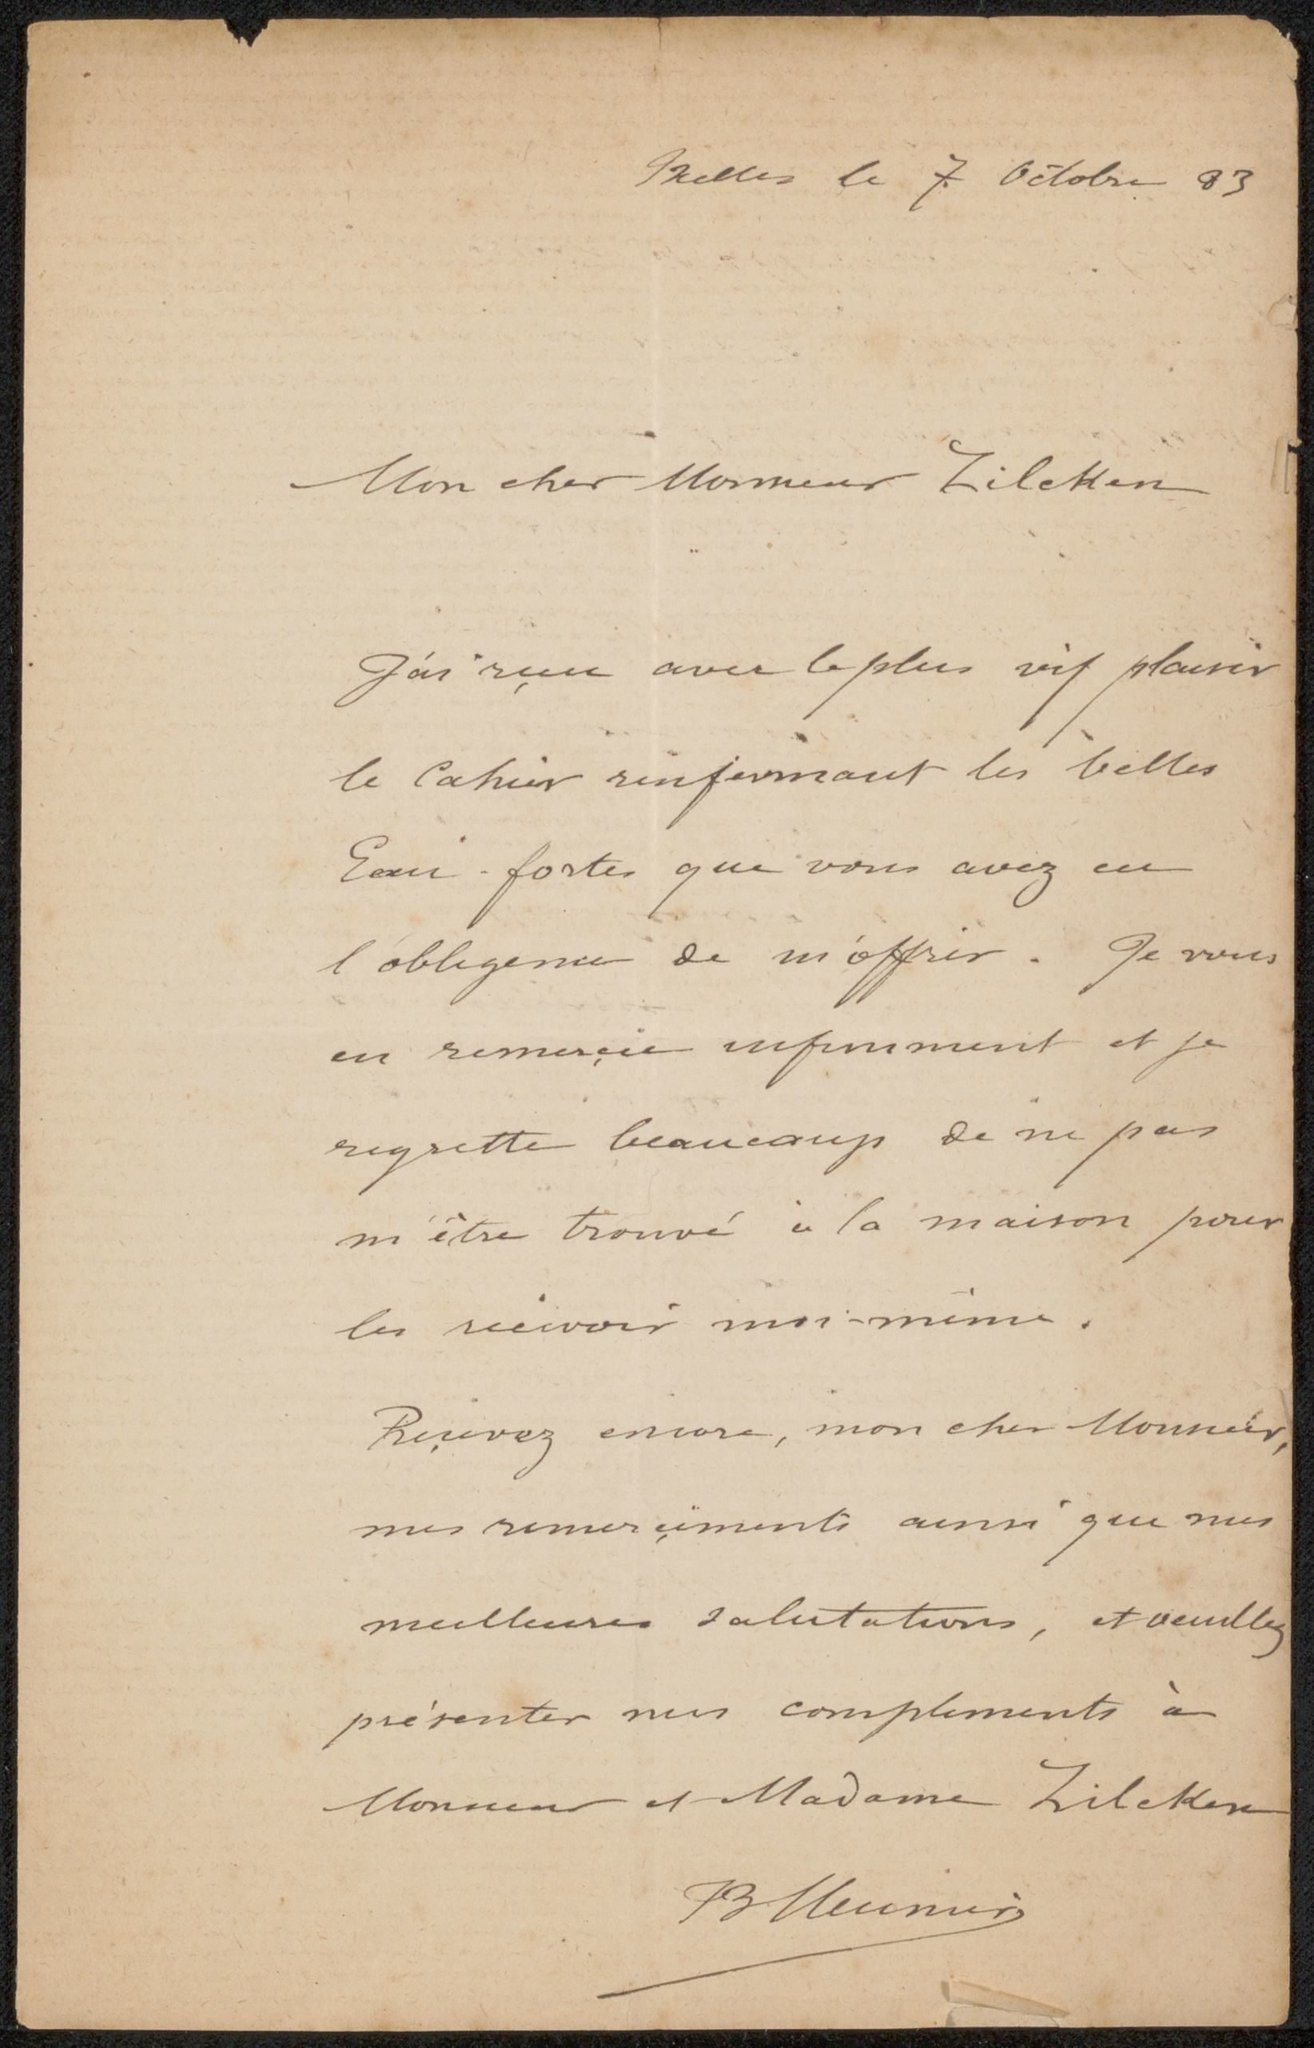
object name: letter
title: Brief aan Philip Zilcken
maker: jean-baptiste meunier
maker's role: print maker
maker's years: 1821-1900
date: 1883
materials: ink, paper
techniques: pen, writing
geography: elsene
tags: the hague, painter, draughtsman, philip zilcken, the graphic arts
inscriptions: collector's mark: ‘RPK’